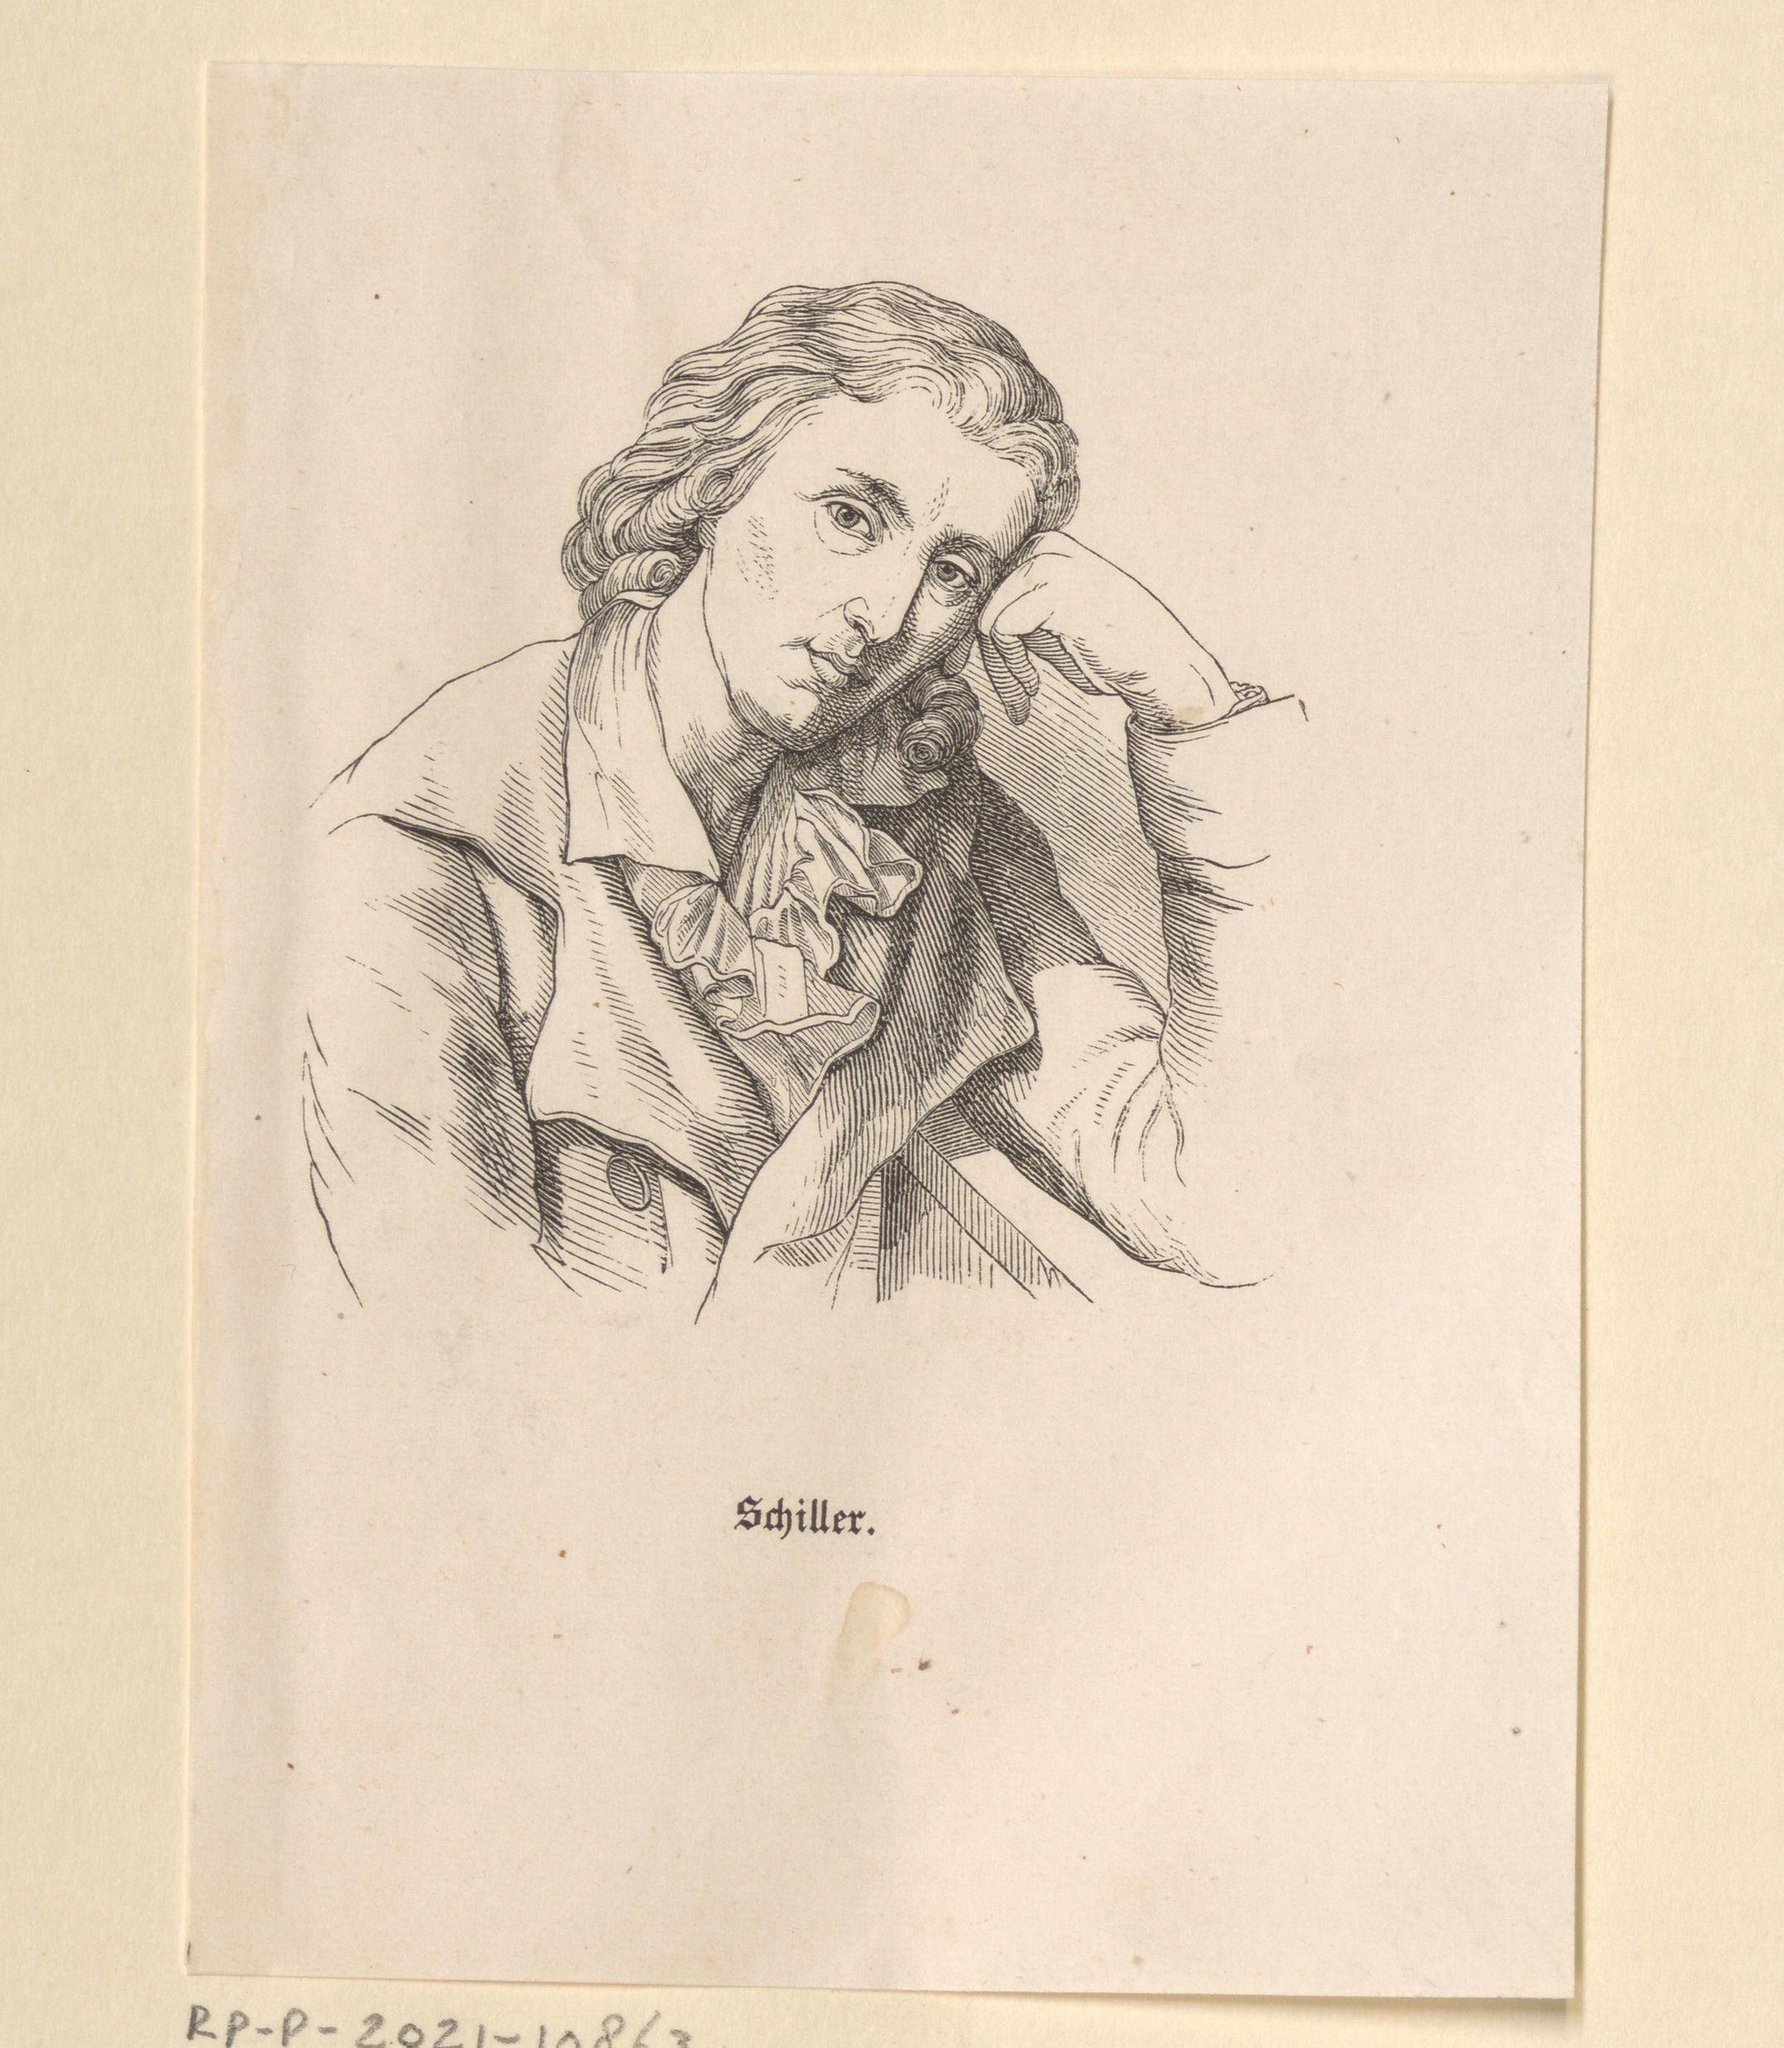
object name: print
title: Portret van Friedrich von Schiller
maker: Anonymous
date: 1854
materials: paper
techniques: letterpress printing, engraving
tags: friedrich von schiller, scholar, philosopher, historical persons, portrait of a writer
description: Prent met andere tekst in boekdruk gebruikt in: Scherr, Johannes. Geschichte der Deutschen Literatur. Leipzig: Otto Wigand, 1854.